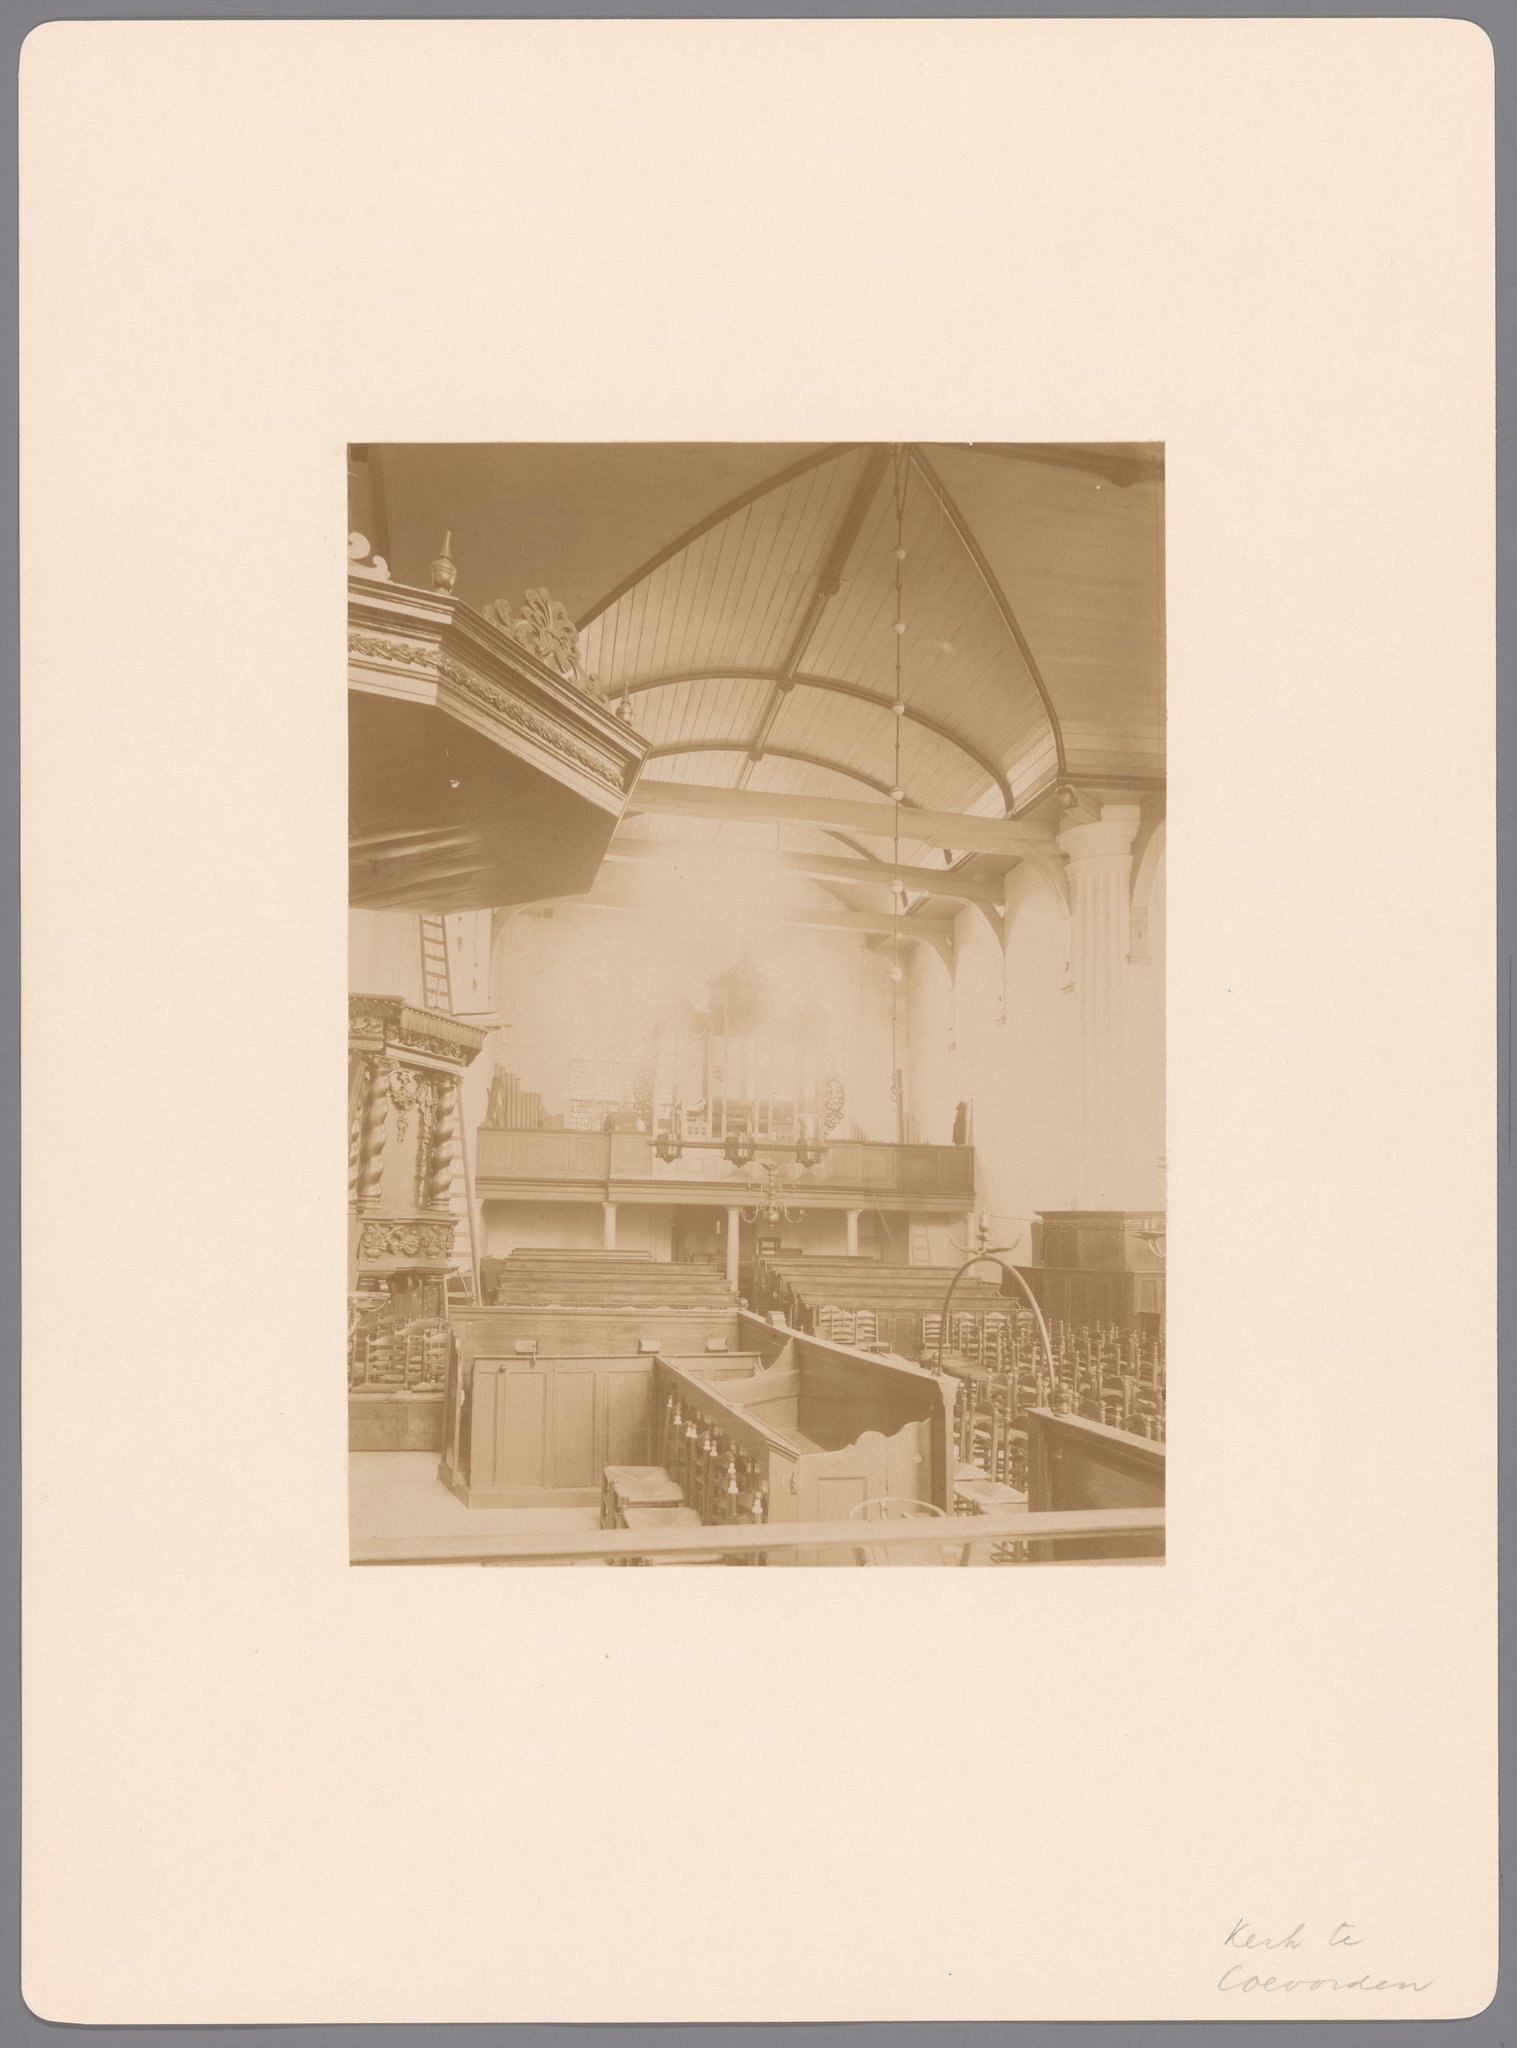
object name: photograph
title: Interieur van de Hervormde Kerk te Coevorden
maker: anoniem (monumentenzorg)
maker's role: fotograaf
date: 1890-1910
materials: cardboard, photographic support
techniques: albumen print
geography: coevorden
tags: interior of church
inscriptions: annotation: ‘Kerk te Coevorden’, annotation: ‘IV’